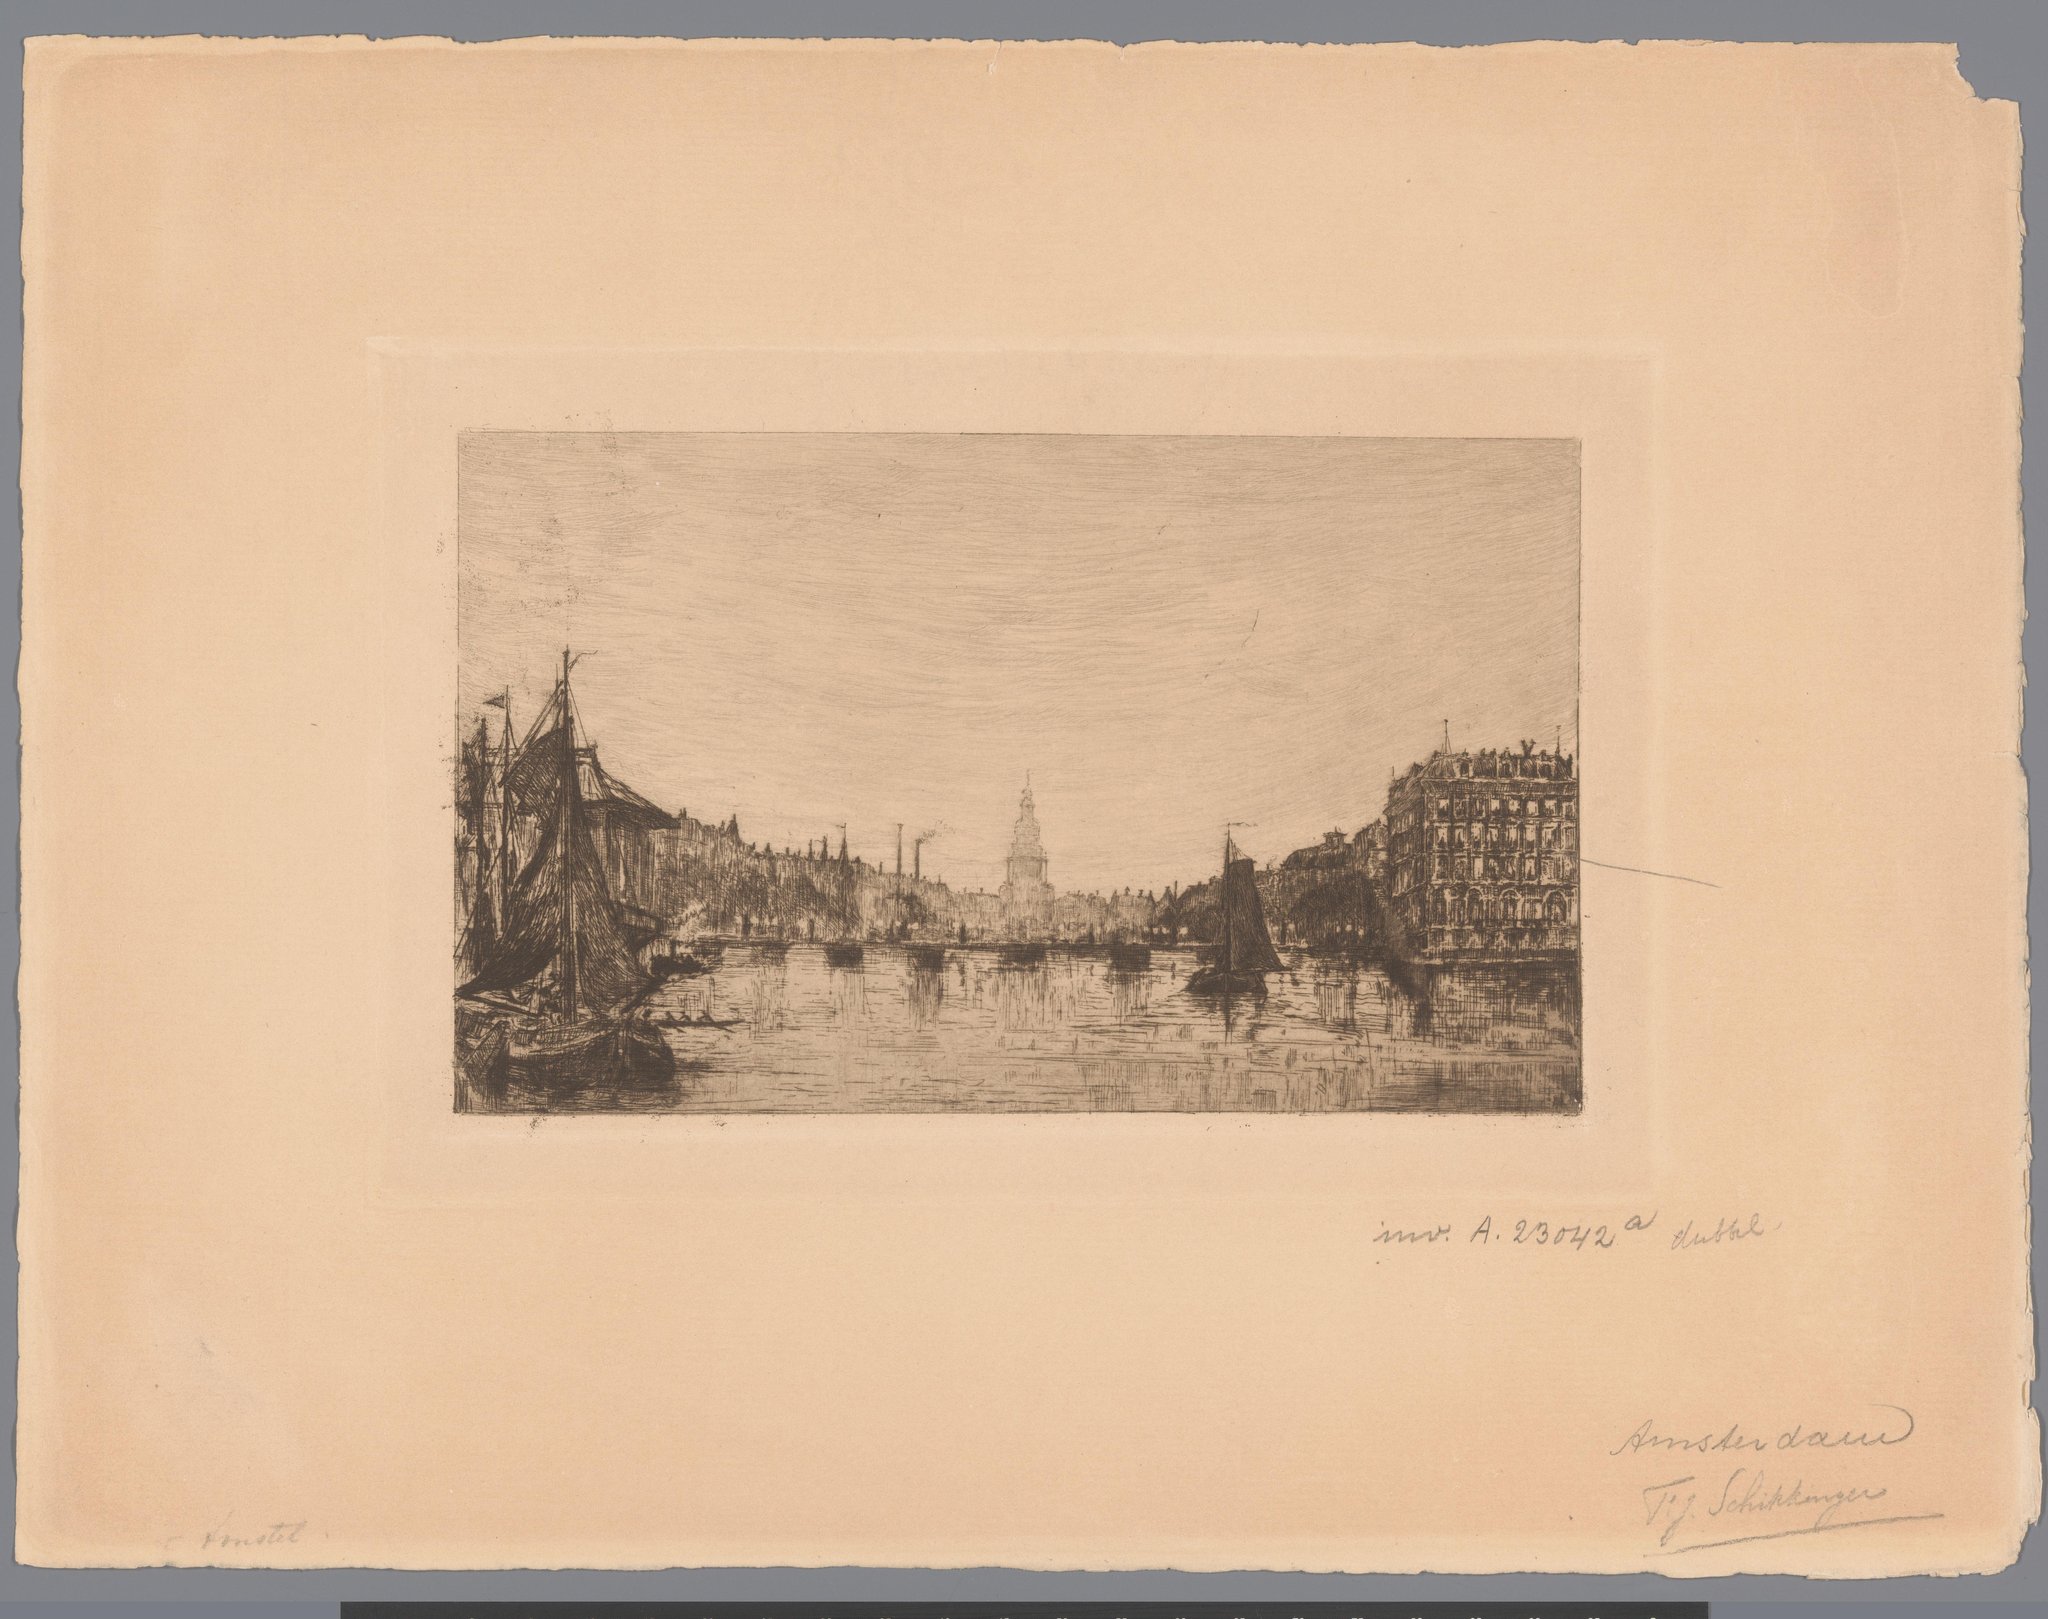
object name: print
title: Gezicht op de Amstel en de Zuiderkerkstoren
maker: frans schikkinger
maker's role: print maker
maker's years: 1838-1902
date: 1867-1902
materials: paper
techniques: drypoint, etching, intaglio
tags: tower, clock tower ~ monumental adornment, canals, waters (in city)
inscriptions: collector's mark: Lugt 2228